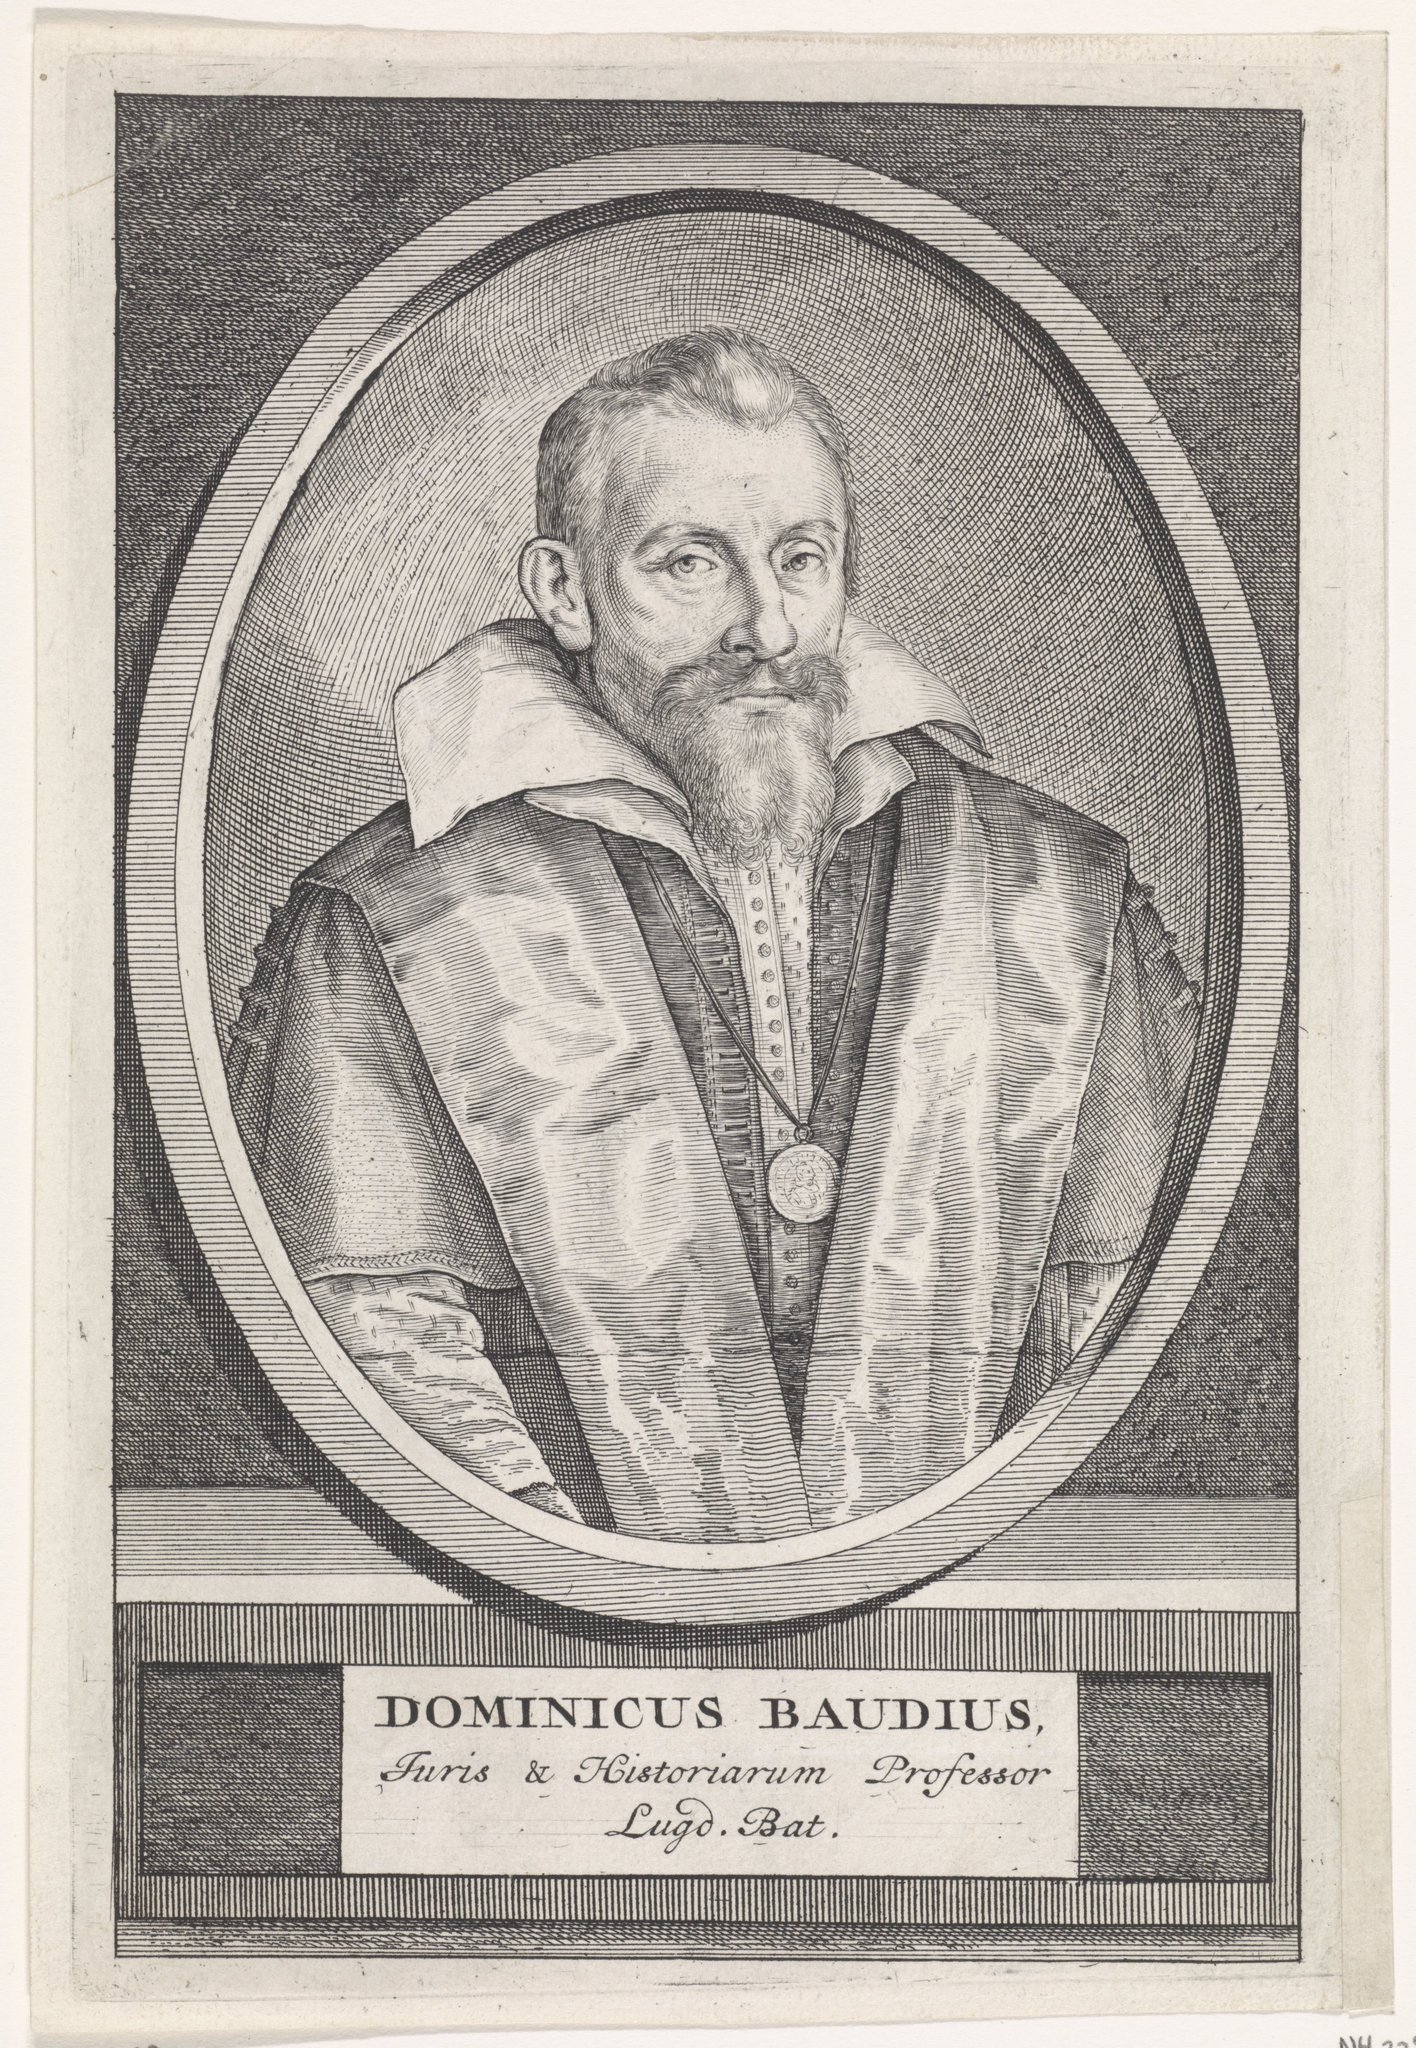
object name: print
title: Portret van Dominicus Baudius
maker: jacob matham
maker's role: draughtsman, print maker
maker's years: 1571-1631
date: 1608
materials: paper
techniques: engraving, etching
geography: haarlem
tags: lille, dominicus baudius, historical persons, portrait of a writer, professor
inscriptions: collector's mark: Lugt 2228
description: Portret van Dominicus Baudius, dichter en professor te Leiden, op 46-jarige leeftijd.